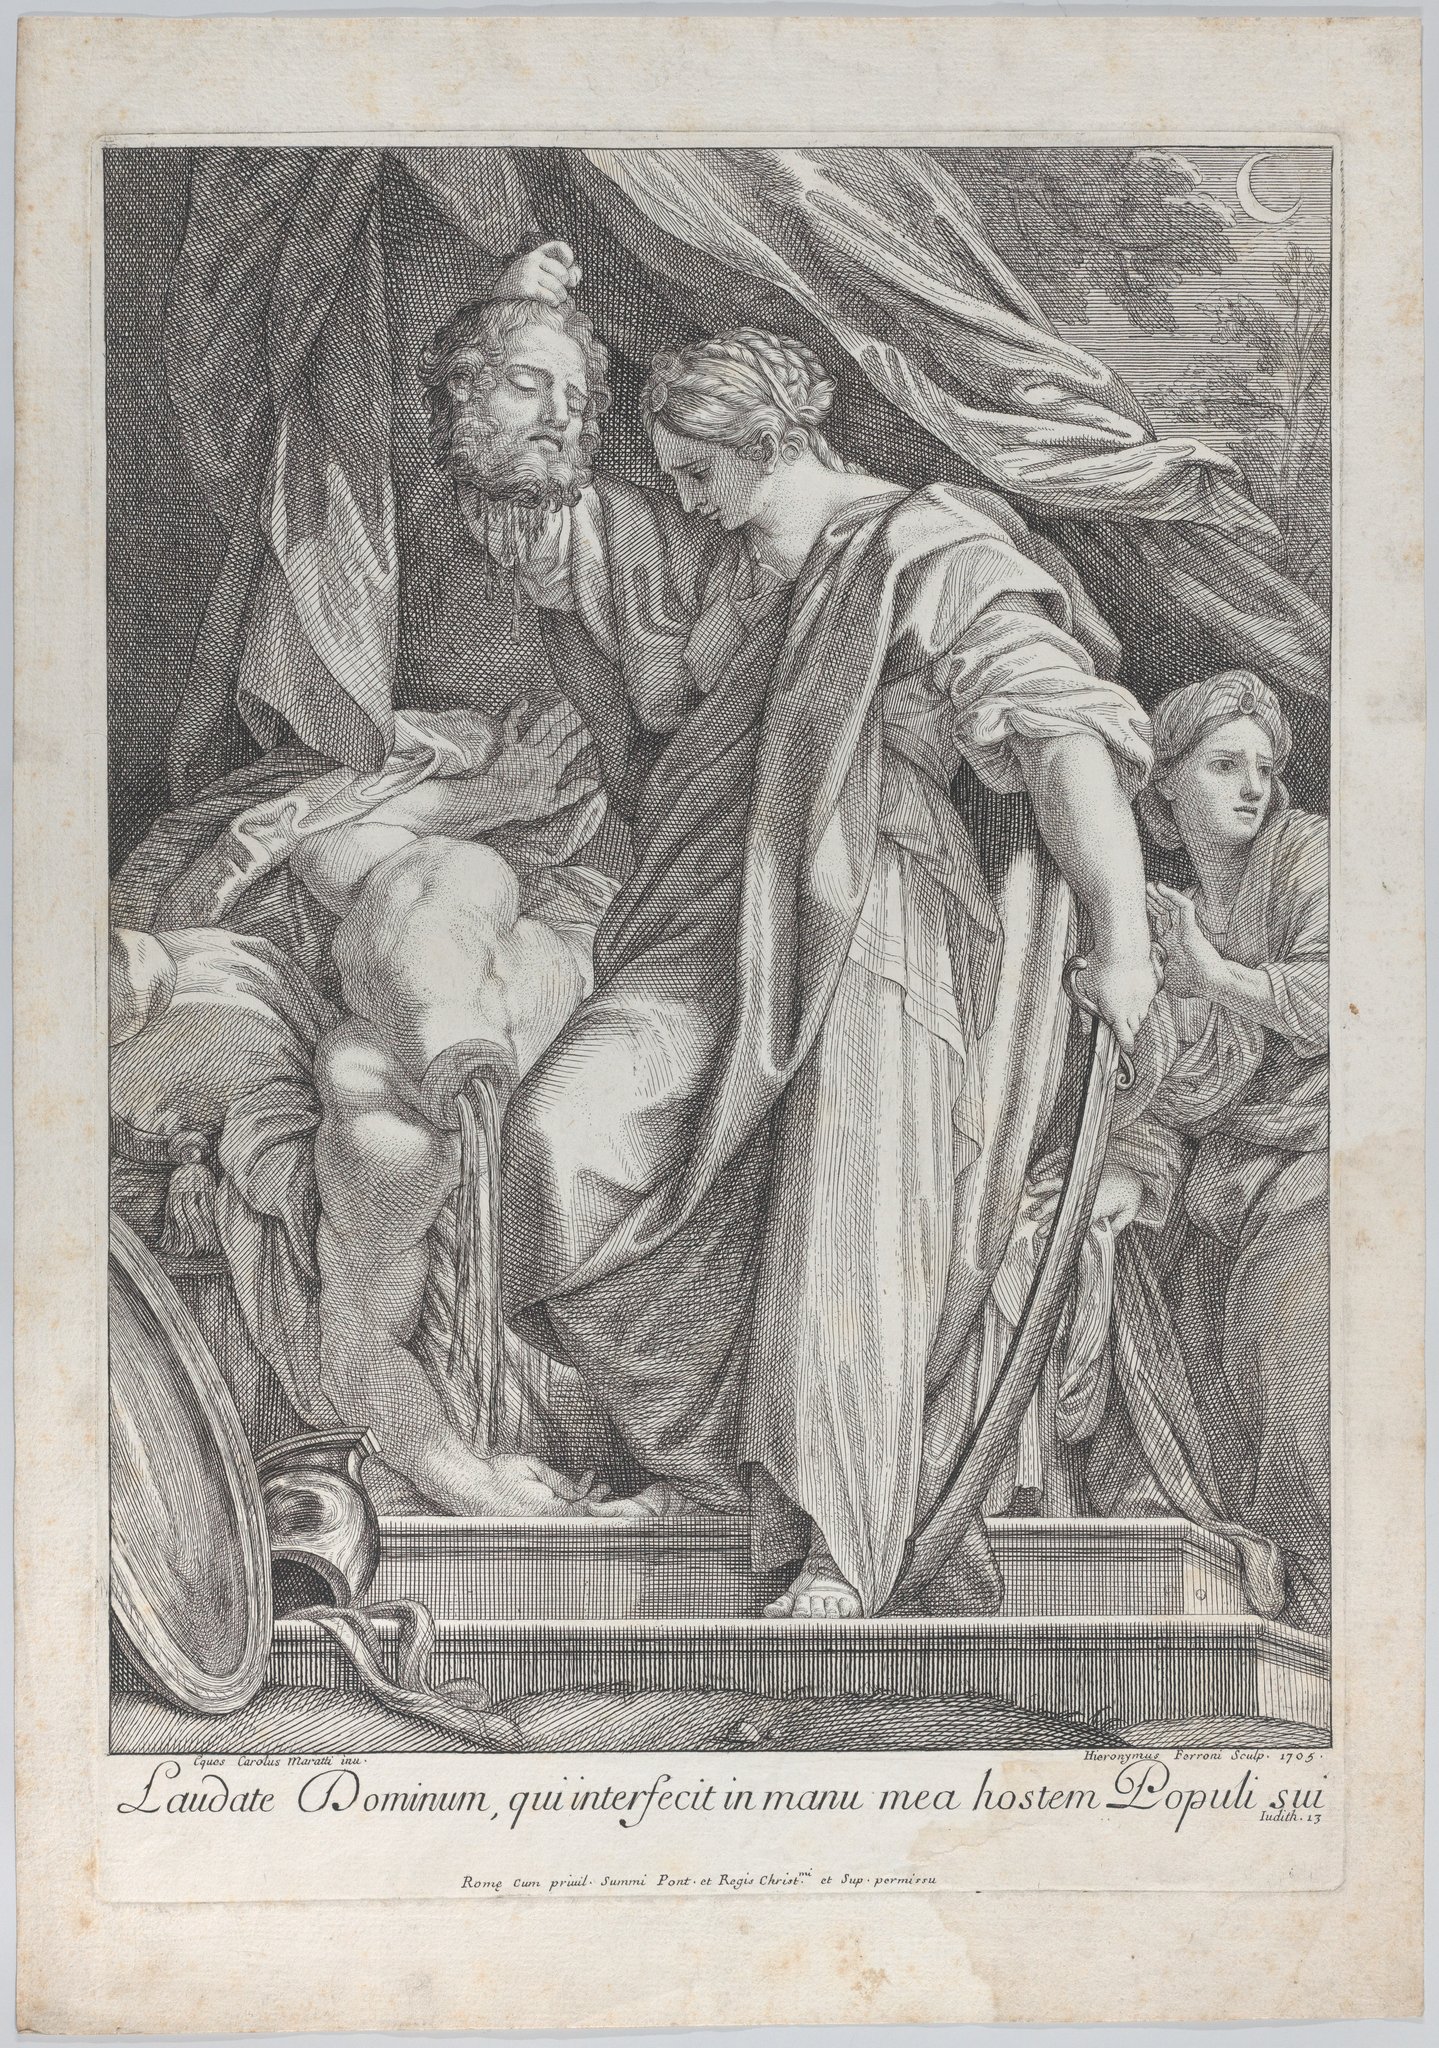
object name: print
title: Judith cutting the head off Holofernes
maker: hieronymus ferroni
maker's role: artist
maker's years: 1687-1730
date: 1705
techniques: engraving